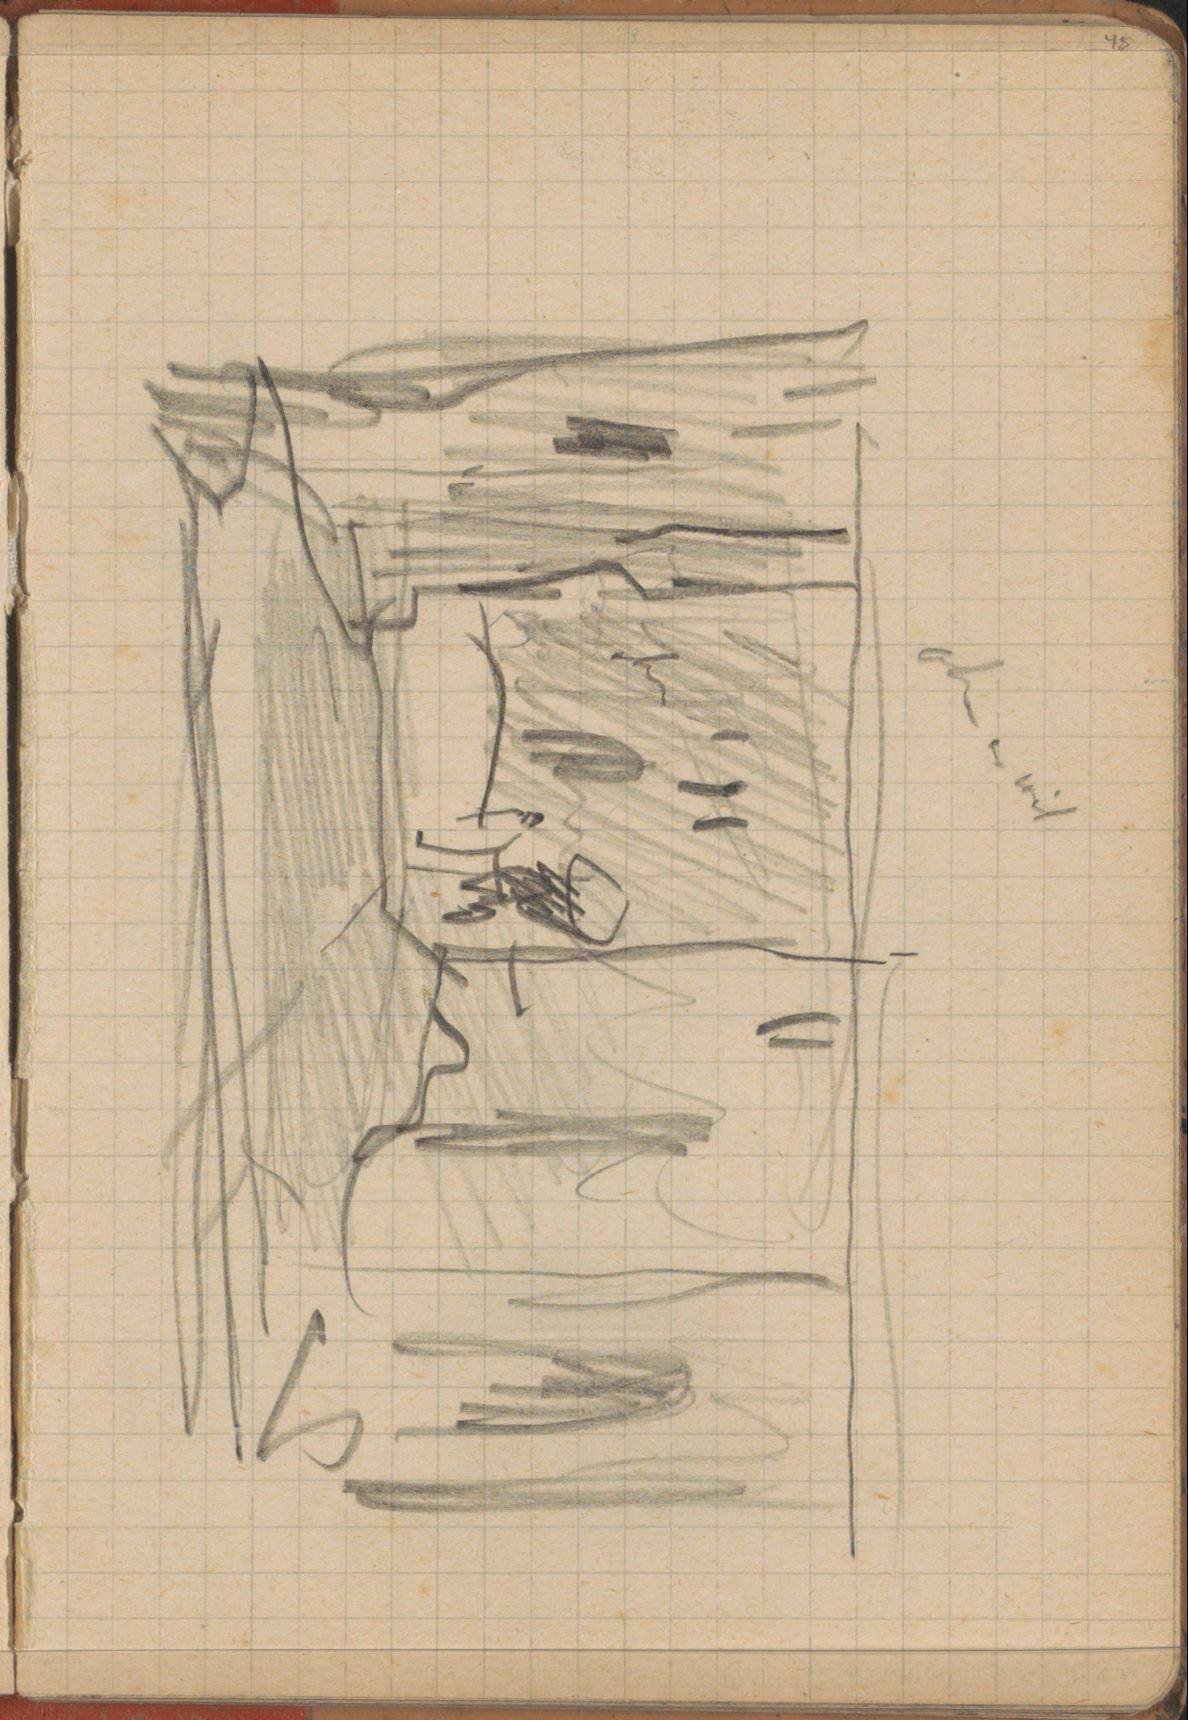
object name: sketchbook leaf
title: Straat met een figuur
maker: marius bauer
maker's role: draughtsman, print maker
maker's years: 1867-1932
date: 1909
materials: pencil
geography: tunis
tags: street (+ city(-scape) with figures, staffage)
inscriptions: kleurnotitie, handgeschreven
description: Pagina 45 uit een schetsboek met 67 bladen.